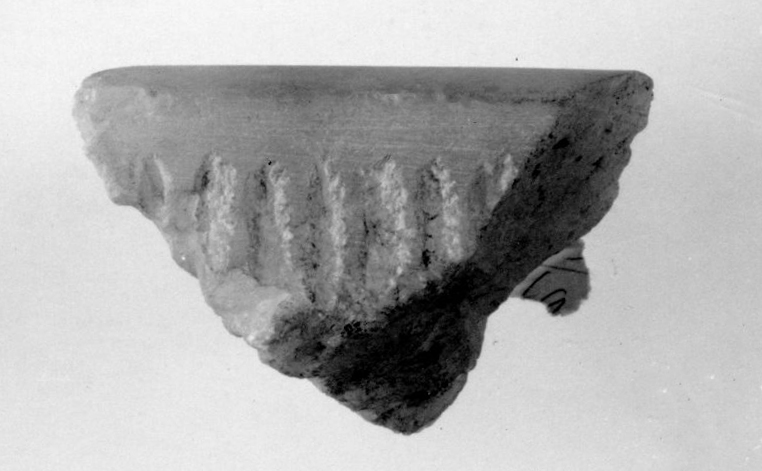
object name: canopic chest fragment, siptah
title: Canopic Chest Lid Fragment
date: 1194-1188 BCE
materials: stone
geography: egypt